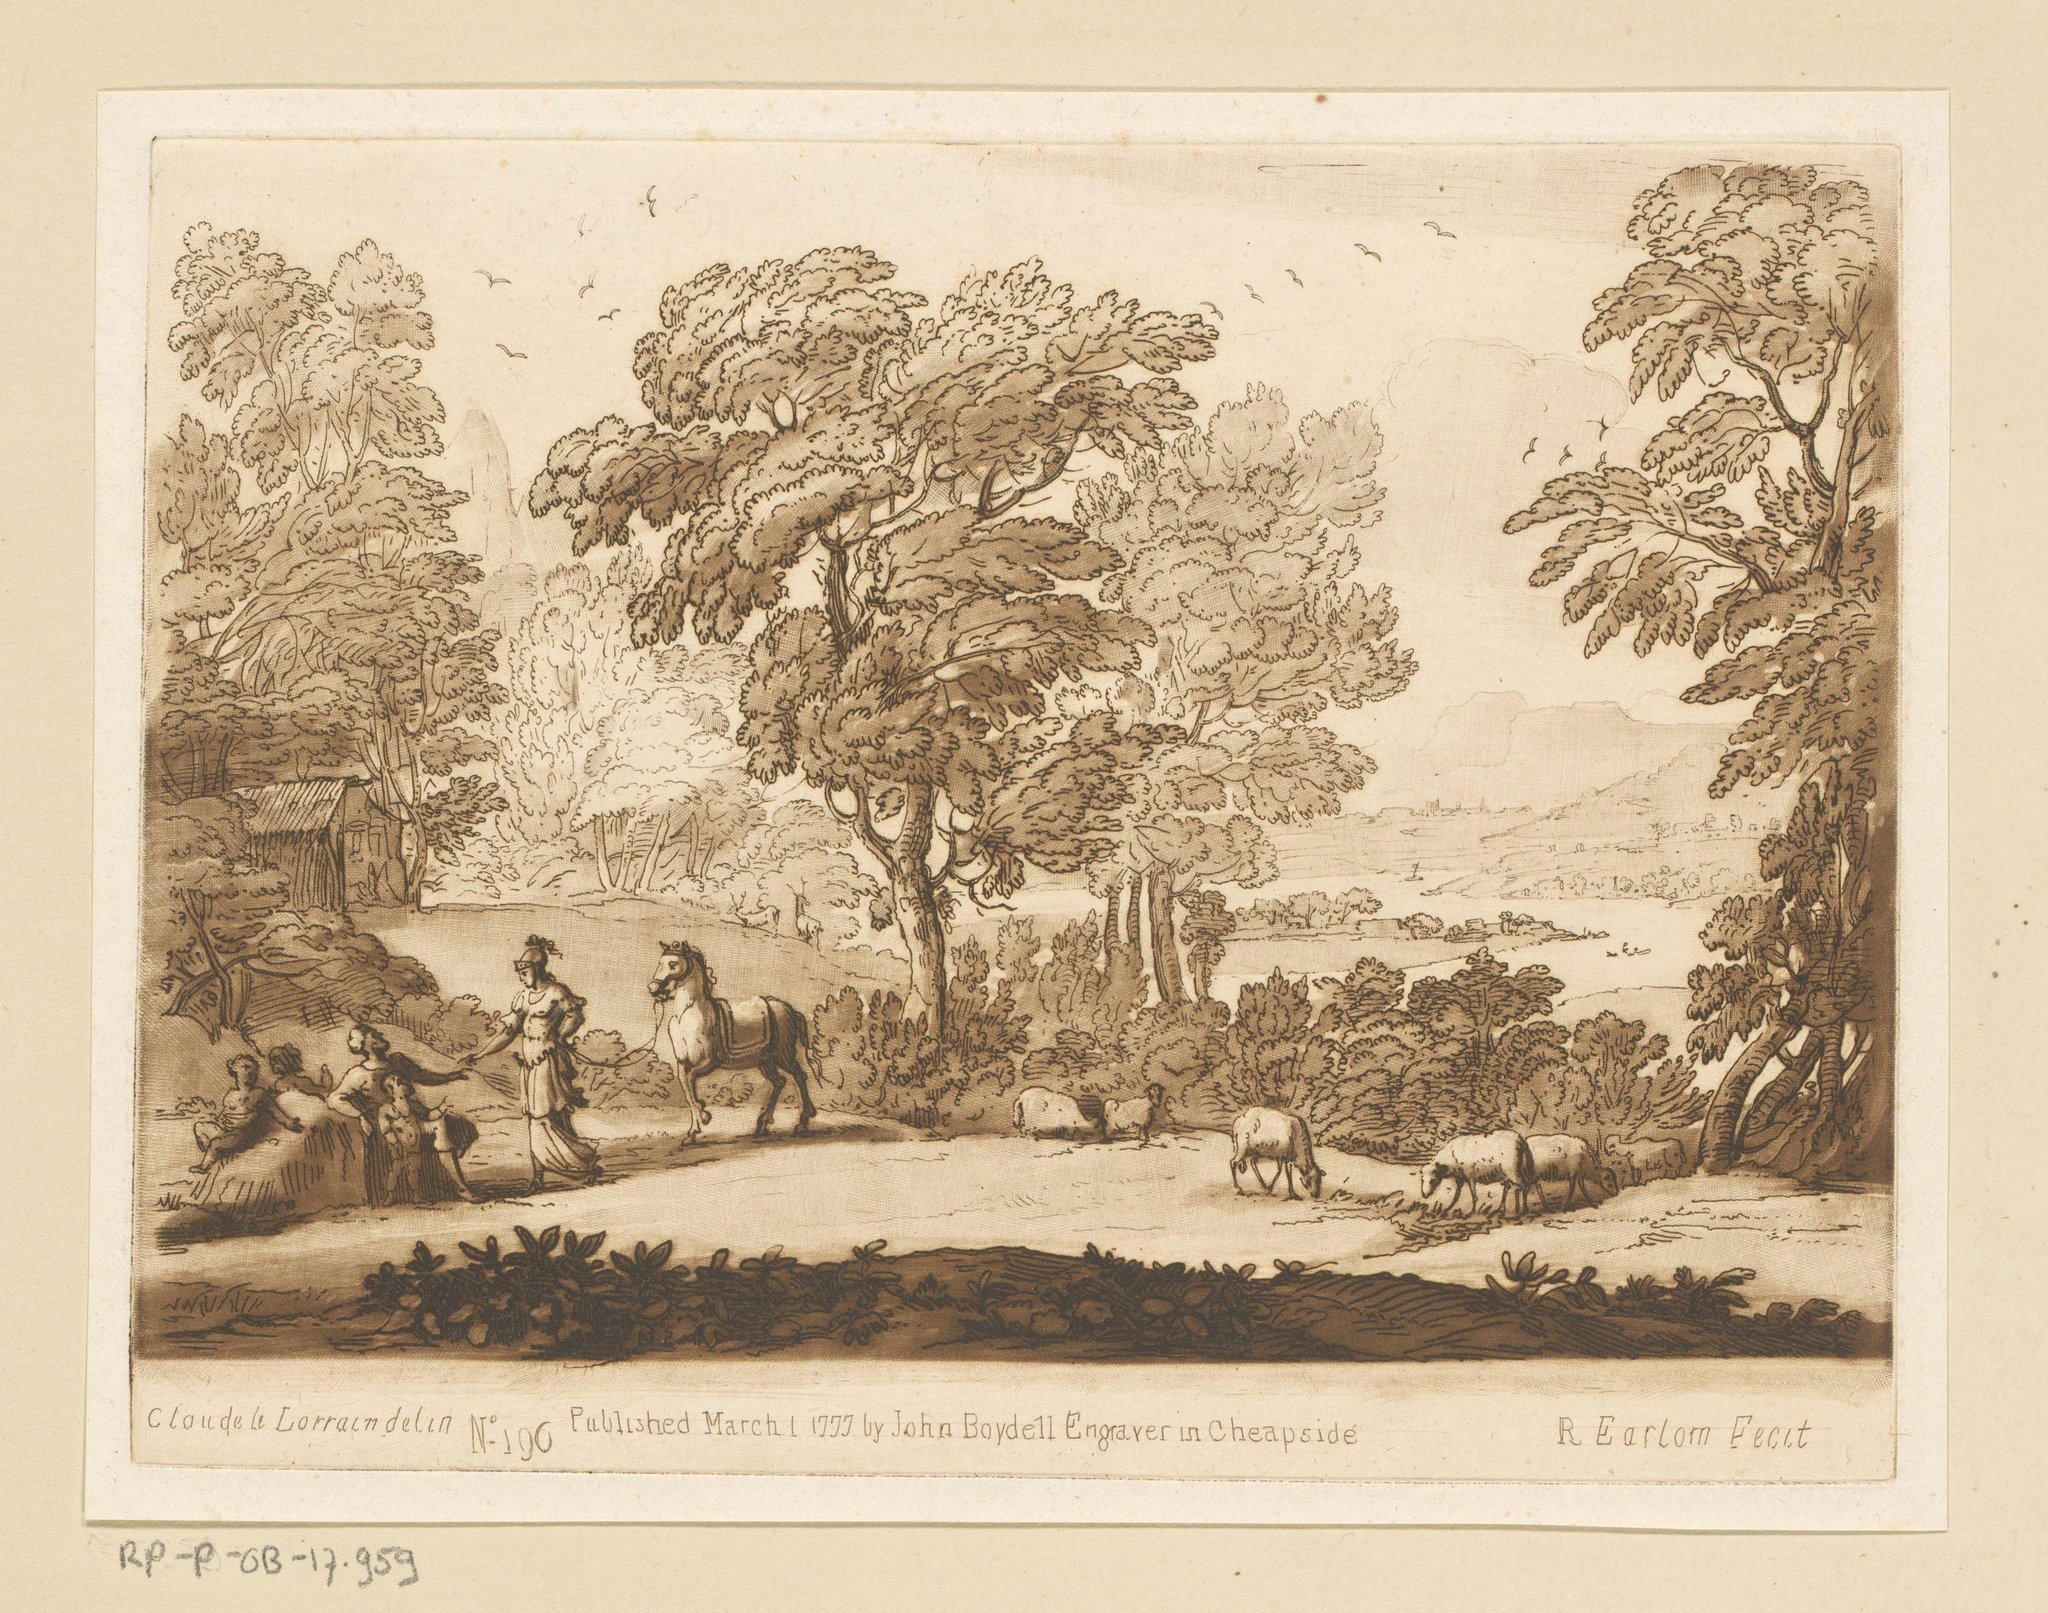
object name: print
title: Liber Veritatis. Or a Collection of Two Hundred Prints, after the original designs of Claude le Lorrain (...)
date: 1777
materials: paper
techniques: etching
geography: london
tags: erminia, herding, herdsman, herdswoman, shepherd, shepherdess, cowherd, etc., cattle, (scenes from) specific works of literature: tasso, gerusalemme liberata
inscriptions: date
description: Vanaf 1774 publiceerde John Boydell tweehonderd prenten naar het tekeningenboek Liber Veritatis van Claude Lorrain, in het bezit van de hertogen van Cavendish. Deze prenten werden vanaf 1777 in twee volumes gebundeld uitgegeven.